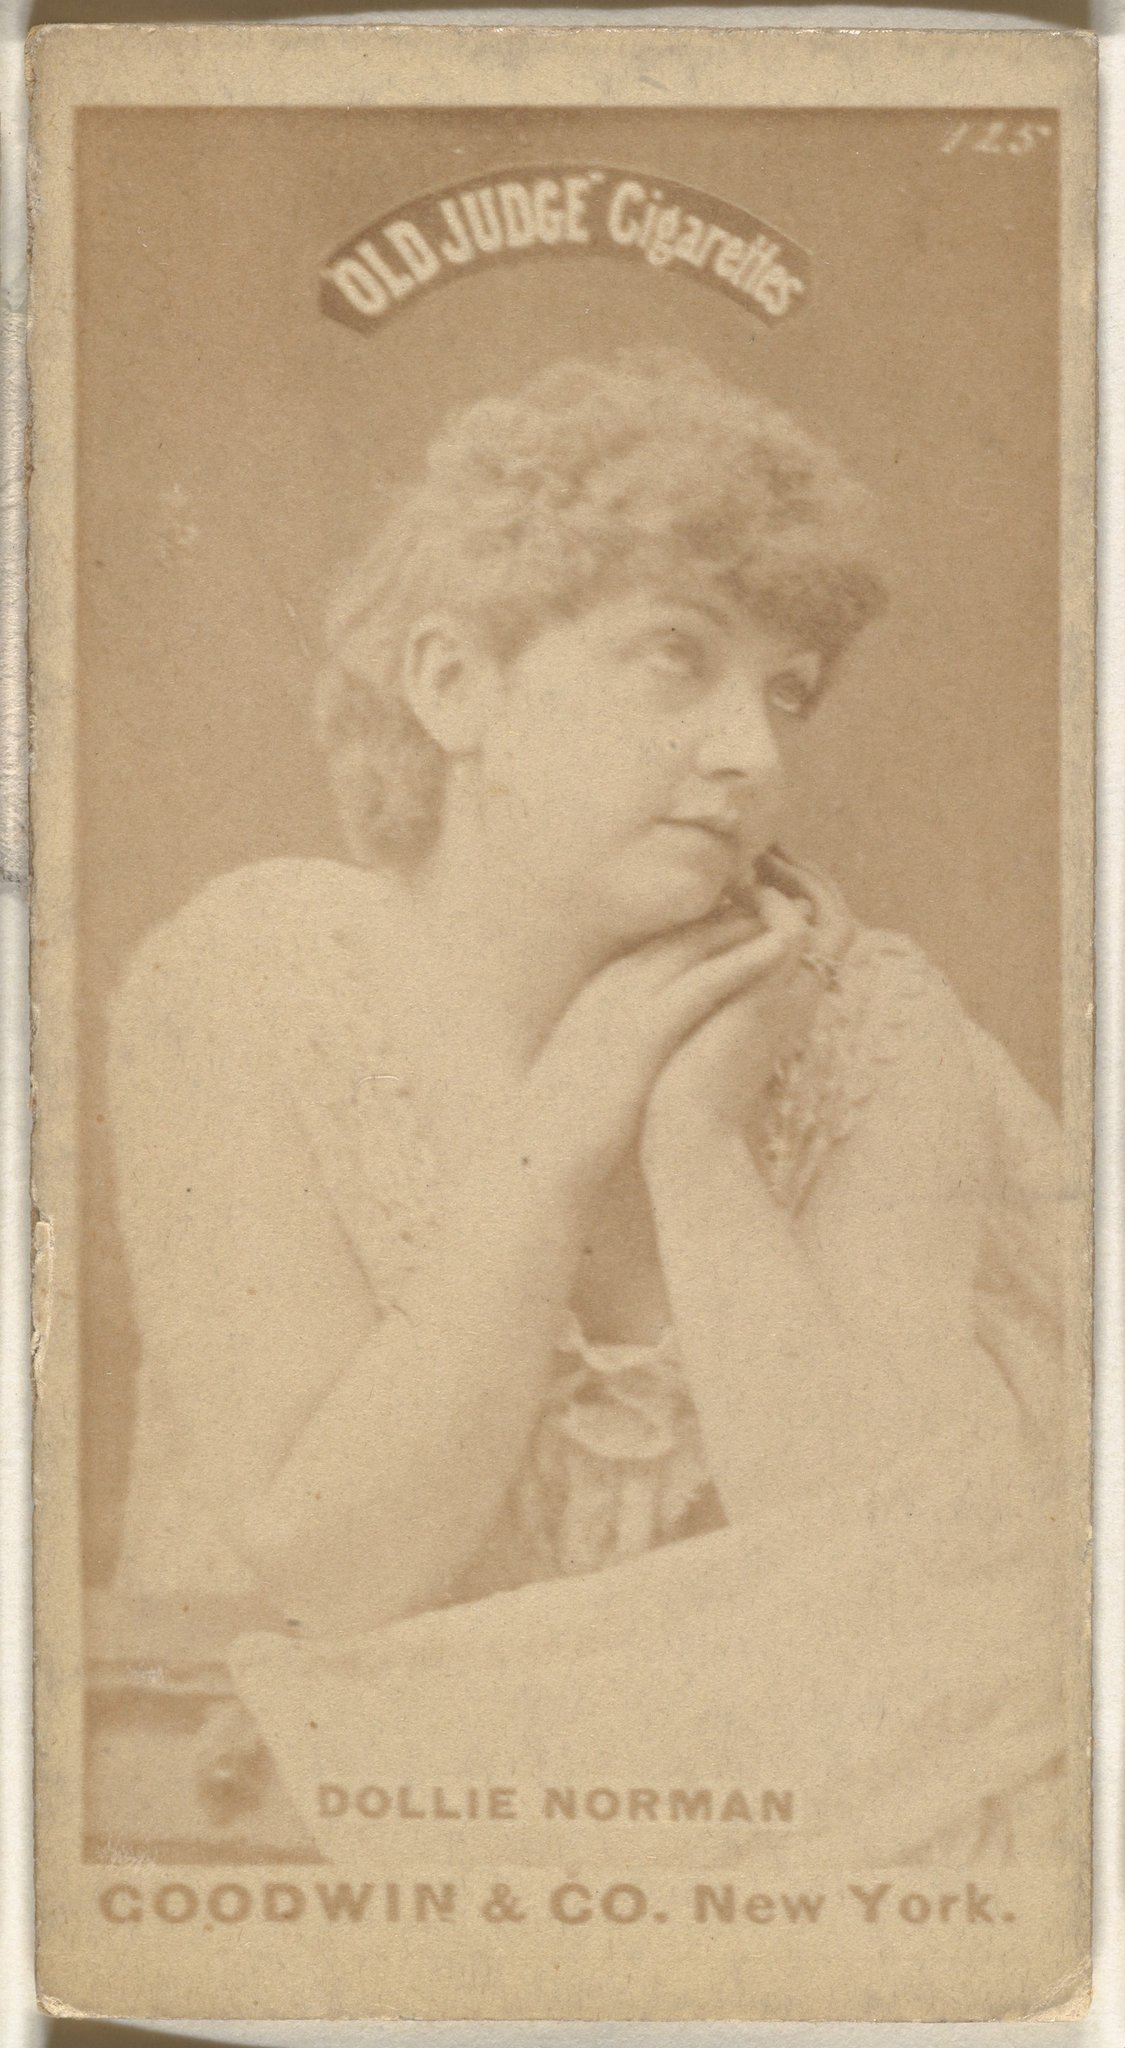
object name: photograph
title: Dollie Norman, from the Actors and Actresses series (N171) for Old Judge Cigarettes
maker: goodwin & company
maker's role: publisher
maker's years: 1850-1950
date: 1886-1890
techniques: albumen silver print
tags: portraits,women,actresses